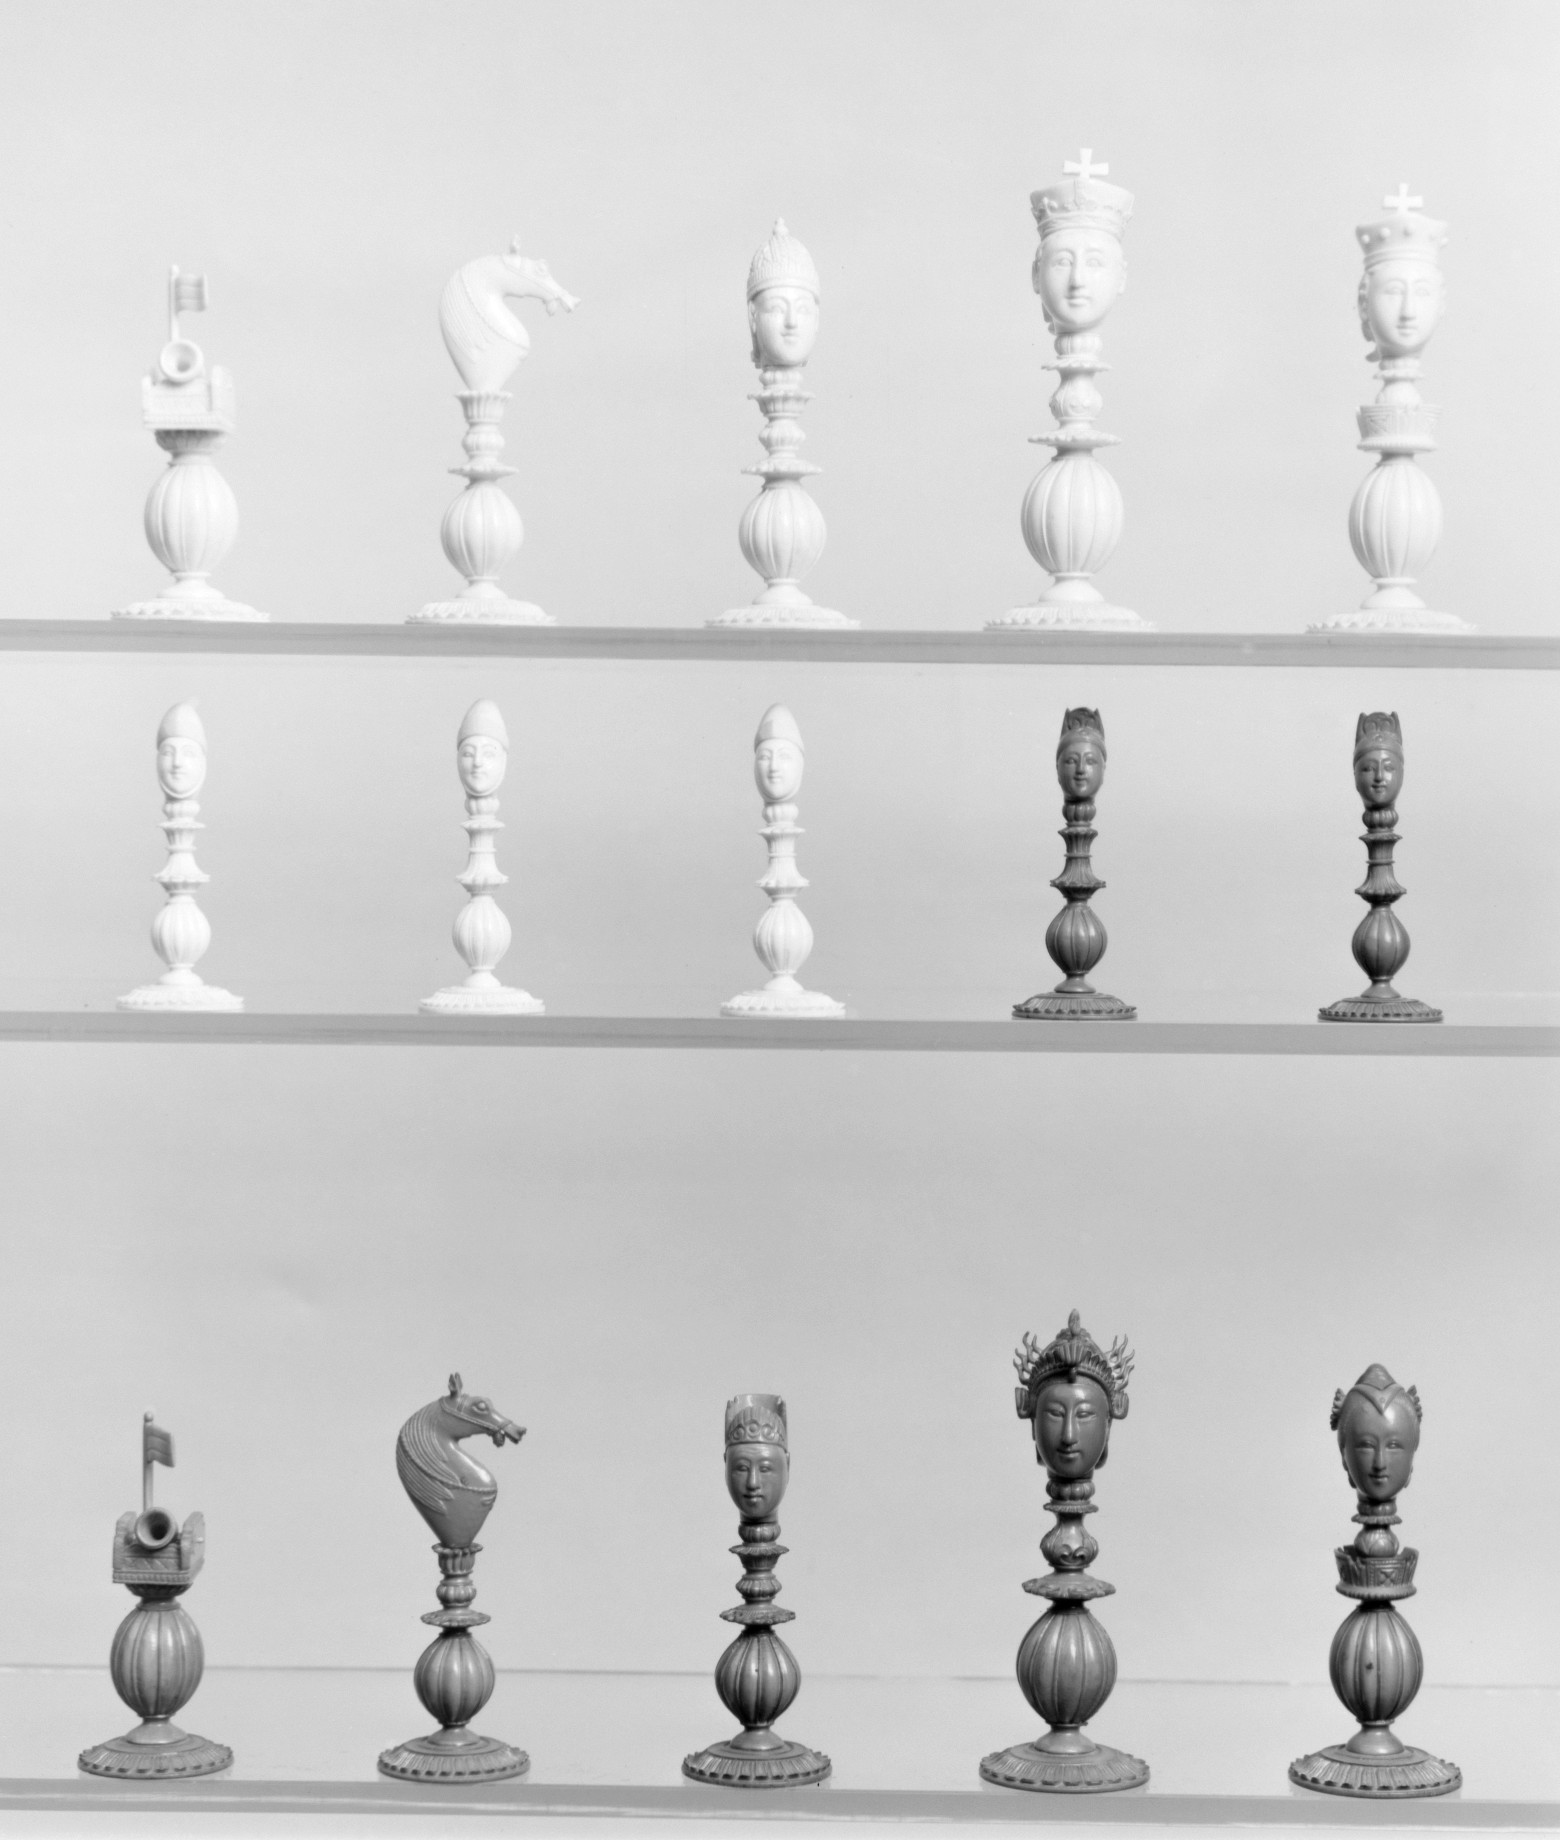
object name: chessman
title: Chessmen (32)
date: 1801-1900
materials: ivory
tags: chess,games